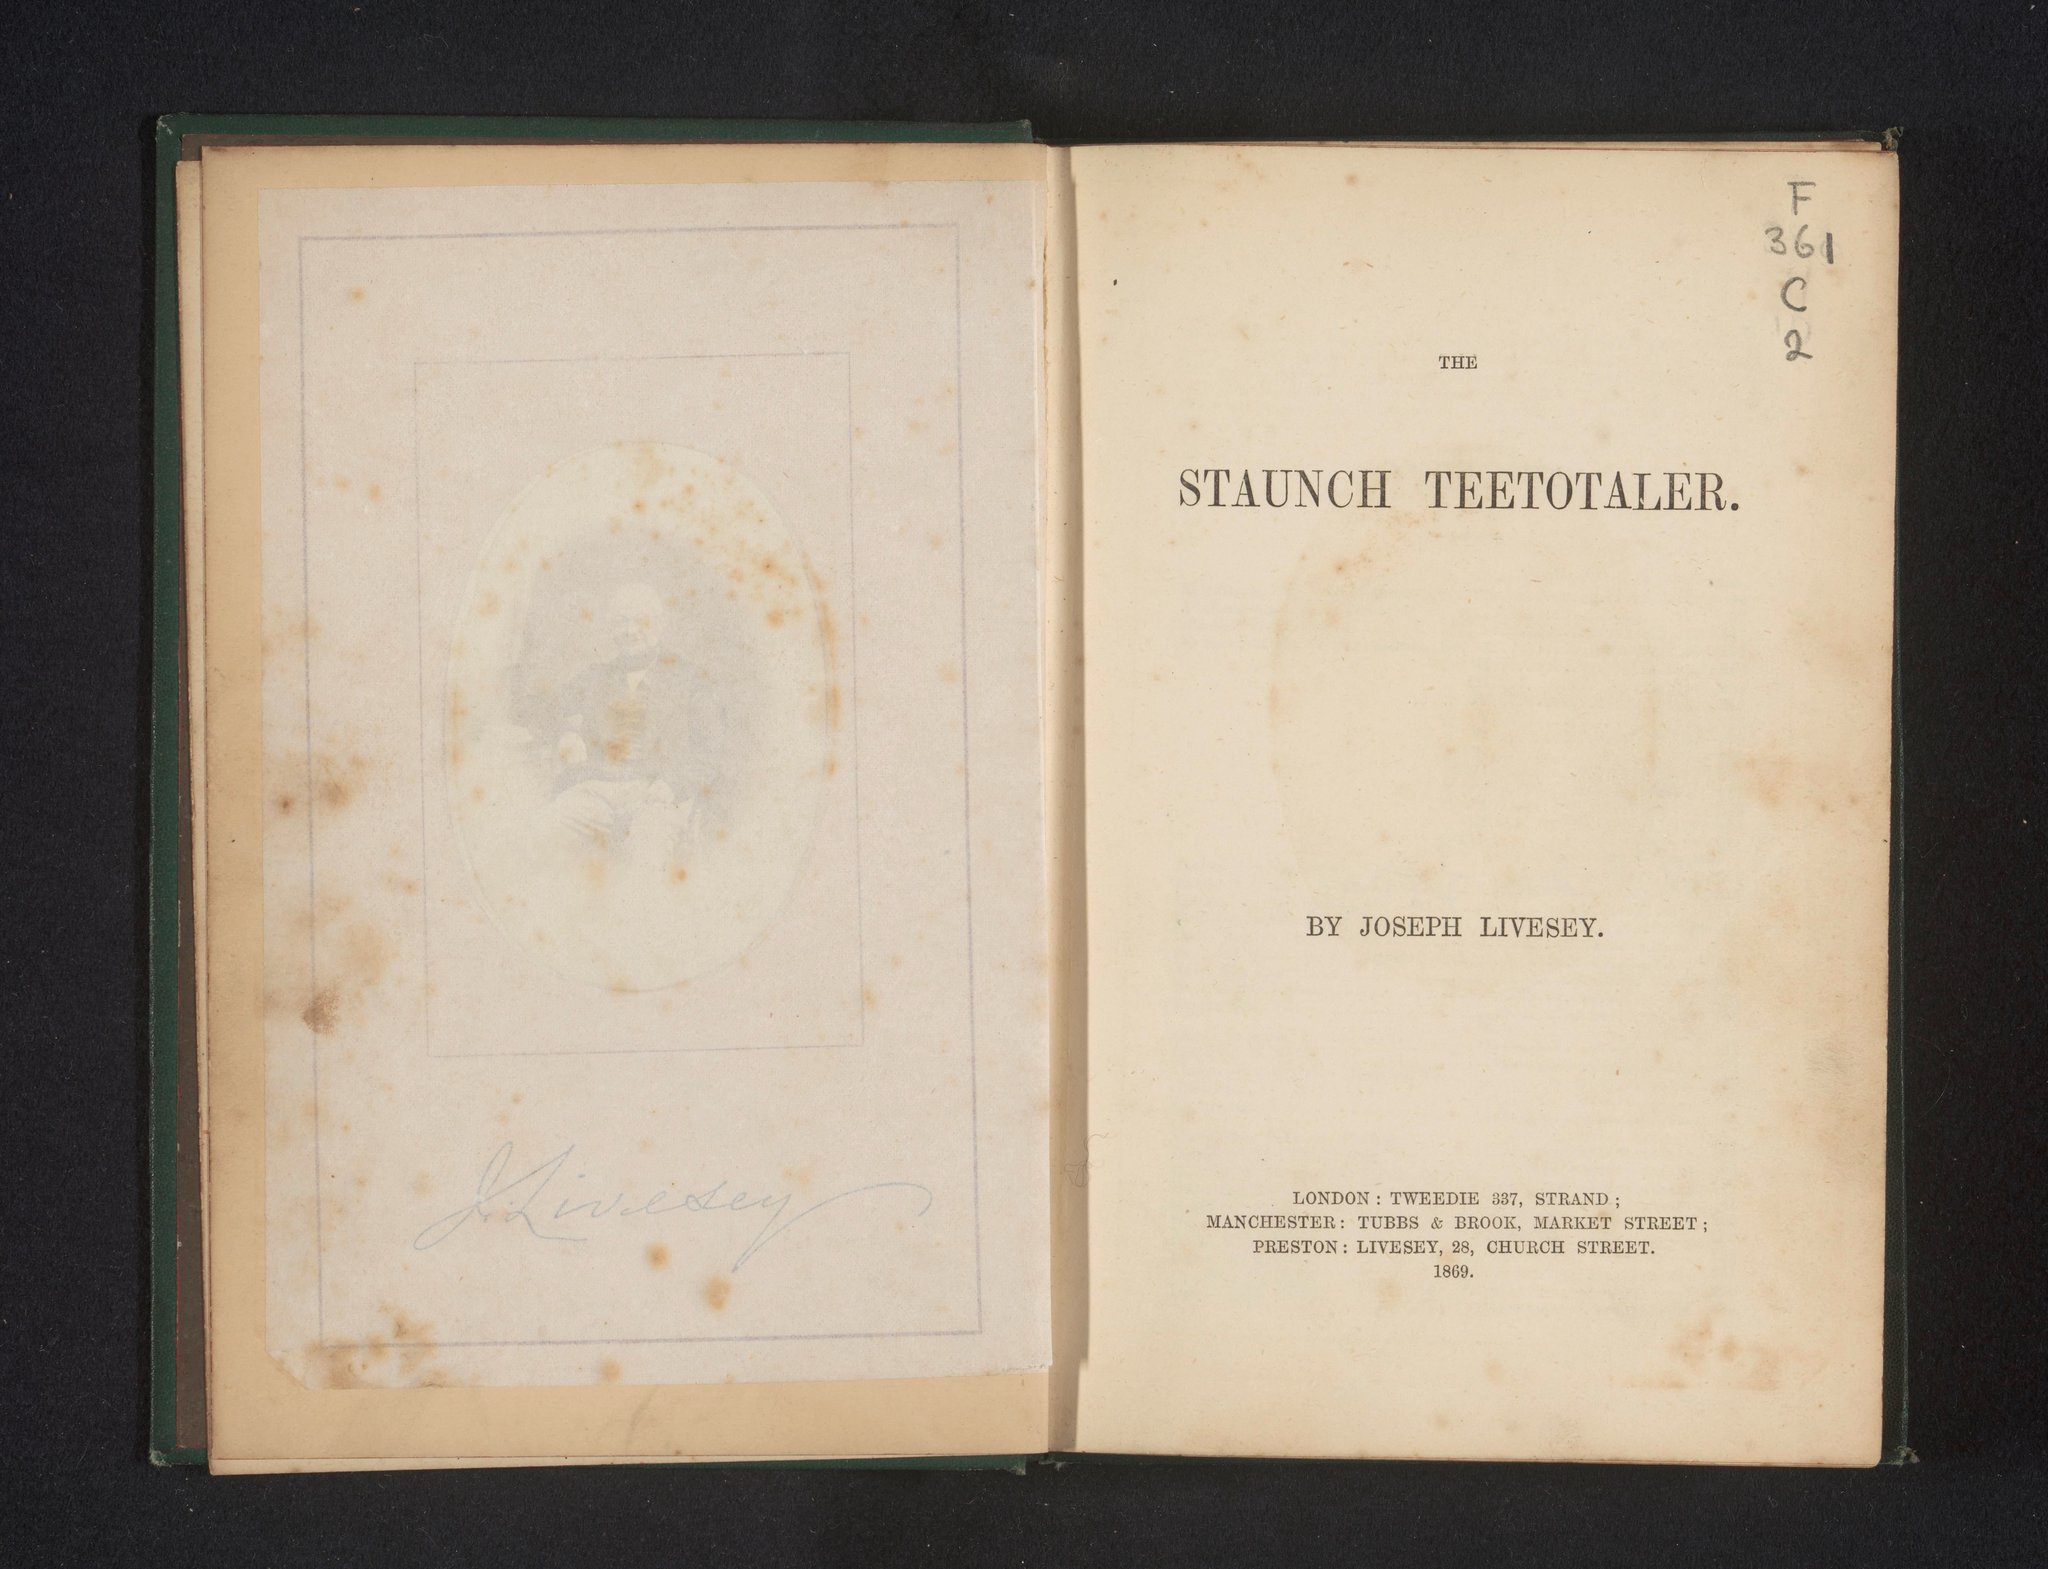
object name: book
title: The staunch teetotaler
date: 1869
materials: cardboard, paper, photographic support, textile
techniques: albumen print, printing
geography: london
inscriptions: annotation: ‘24 issues/ 1867/68/ £ 35 [...]’, annotation: ‘NOV/ 1994’